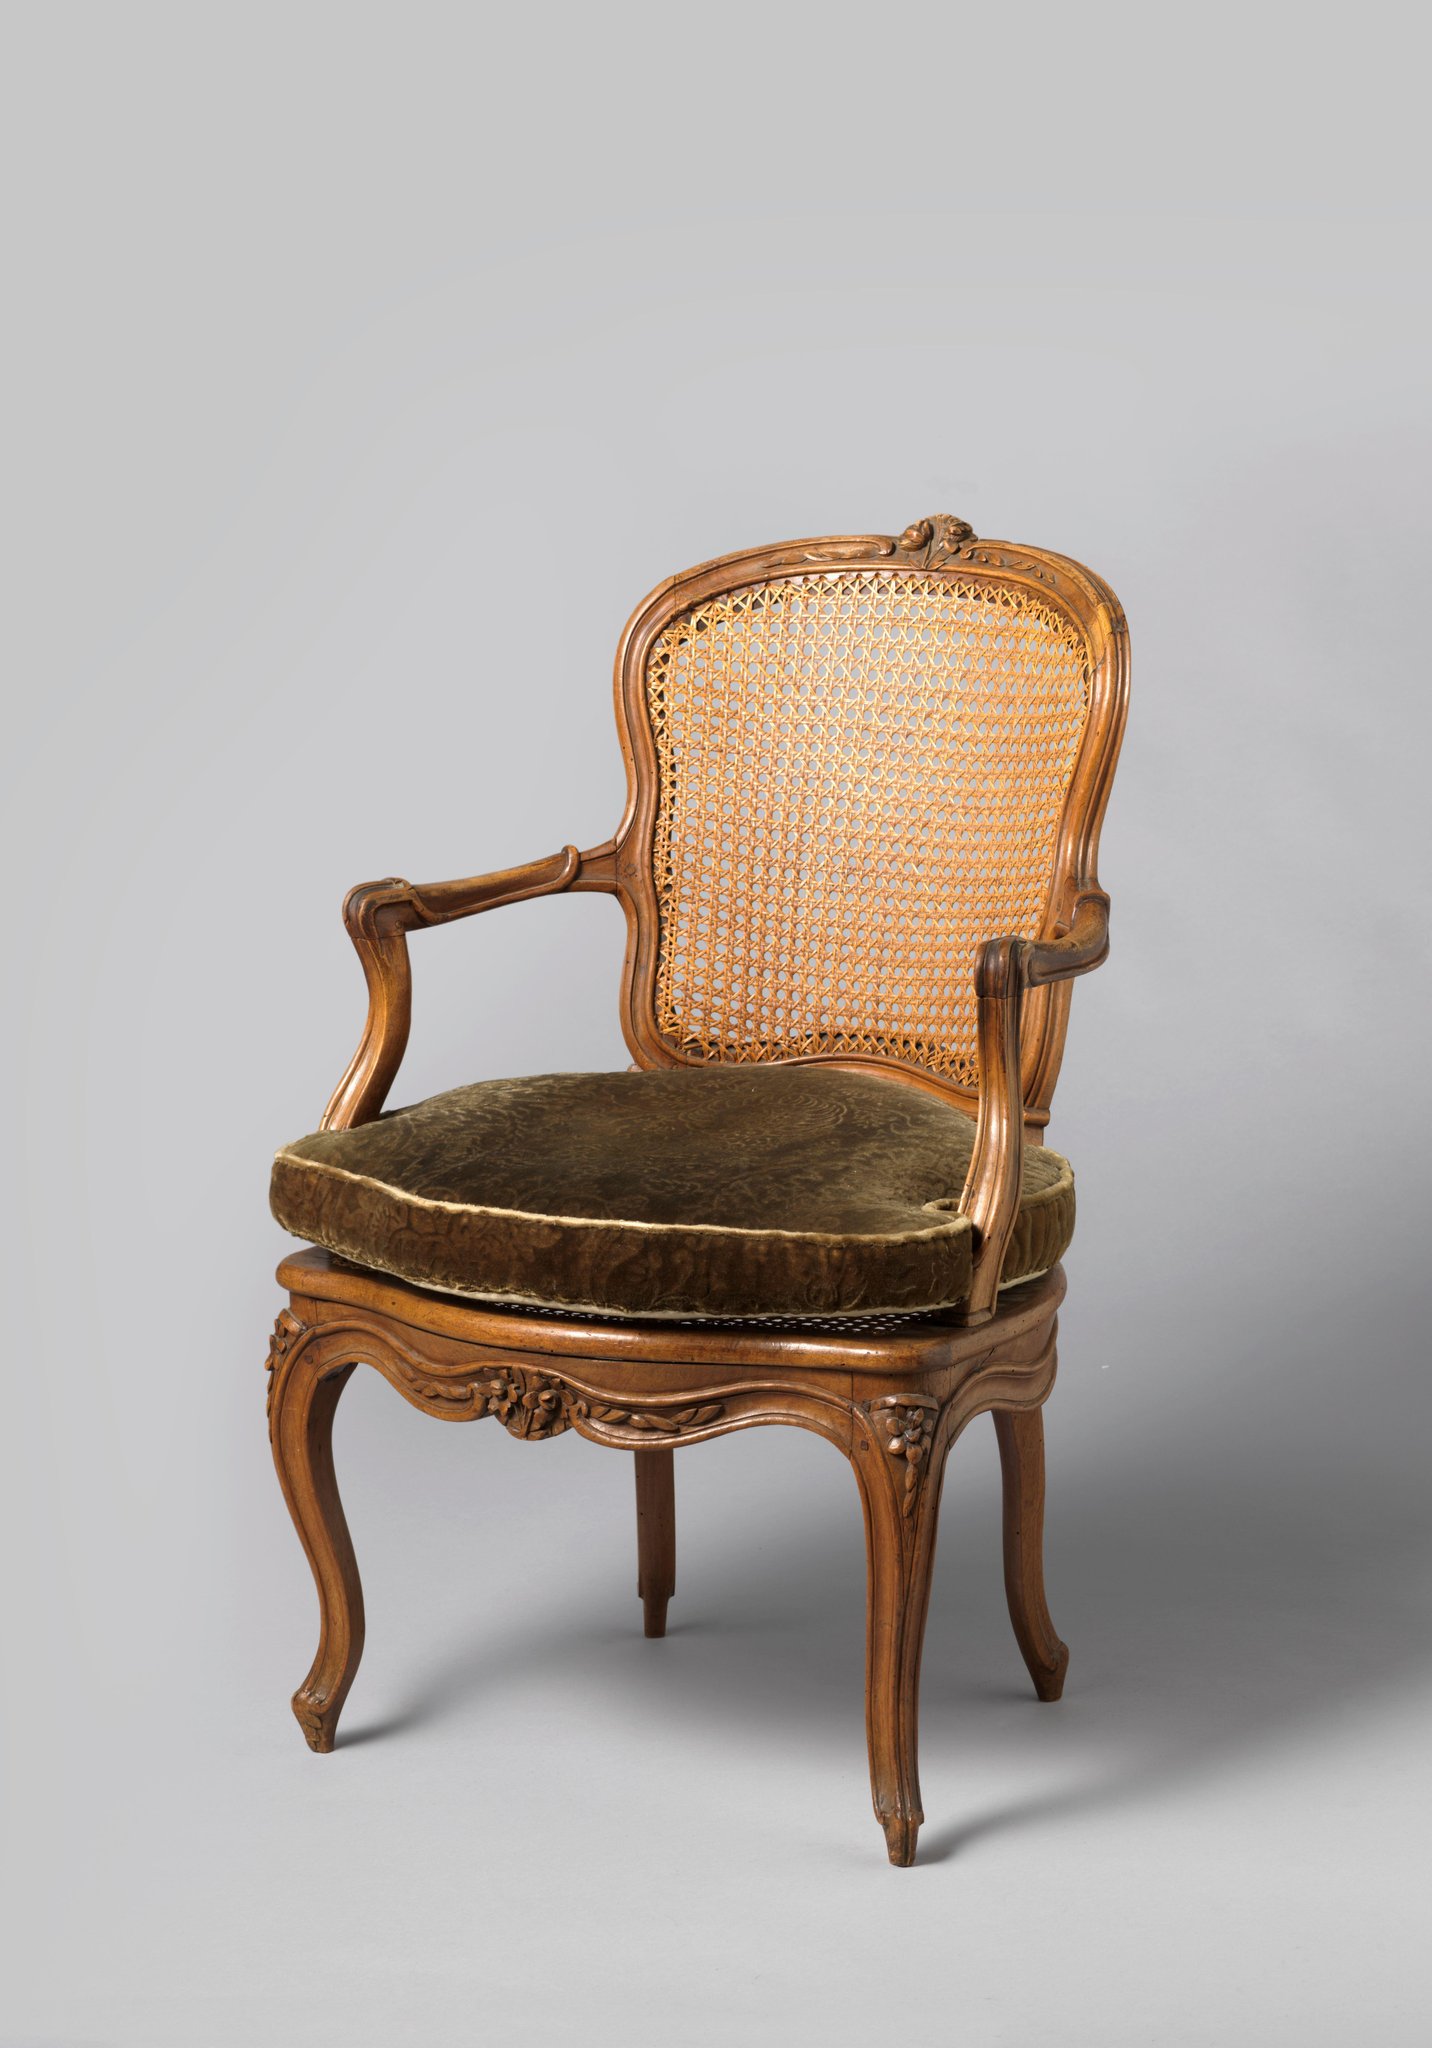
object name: furniture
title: Armstoel van notenhout met S-vormig overhoeks geplaatste poten en snijwerk van bloemen en bladeren. Rug en zitting van gevlochten riet. Met los kussen.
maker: Anonymous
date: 1750-1775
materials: wood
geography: france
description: Armstoel van notenhout (ameublement) met rug en zitting van gevlochten riet. De gestrekt S-vormige overhoeks geplaatste poten met profilering gaan zonder onderbreking in het zitraam over en zijn versierd met gestoken bloemen. Geschulpte voorregel met bloem- en bladwerk. Achterwaarts geplaatste armleggerstutten S-vormig; geholde armleggers eindigend in voluten. Bovenregel raam met gestoken versiering. Met los kussen. Zie ook: BK-16851-A t/m H.